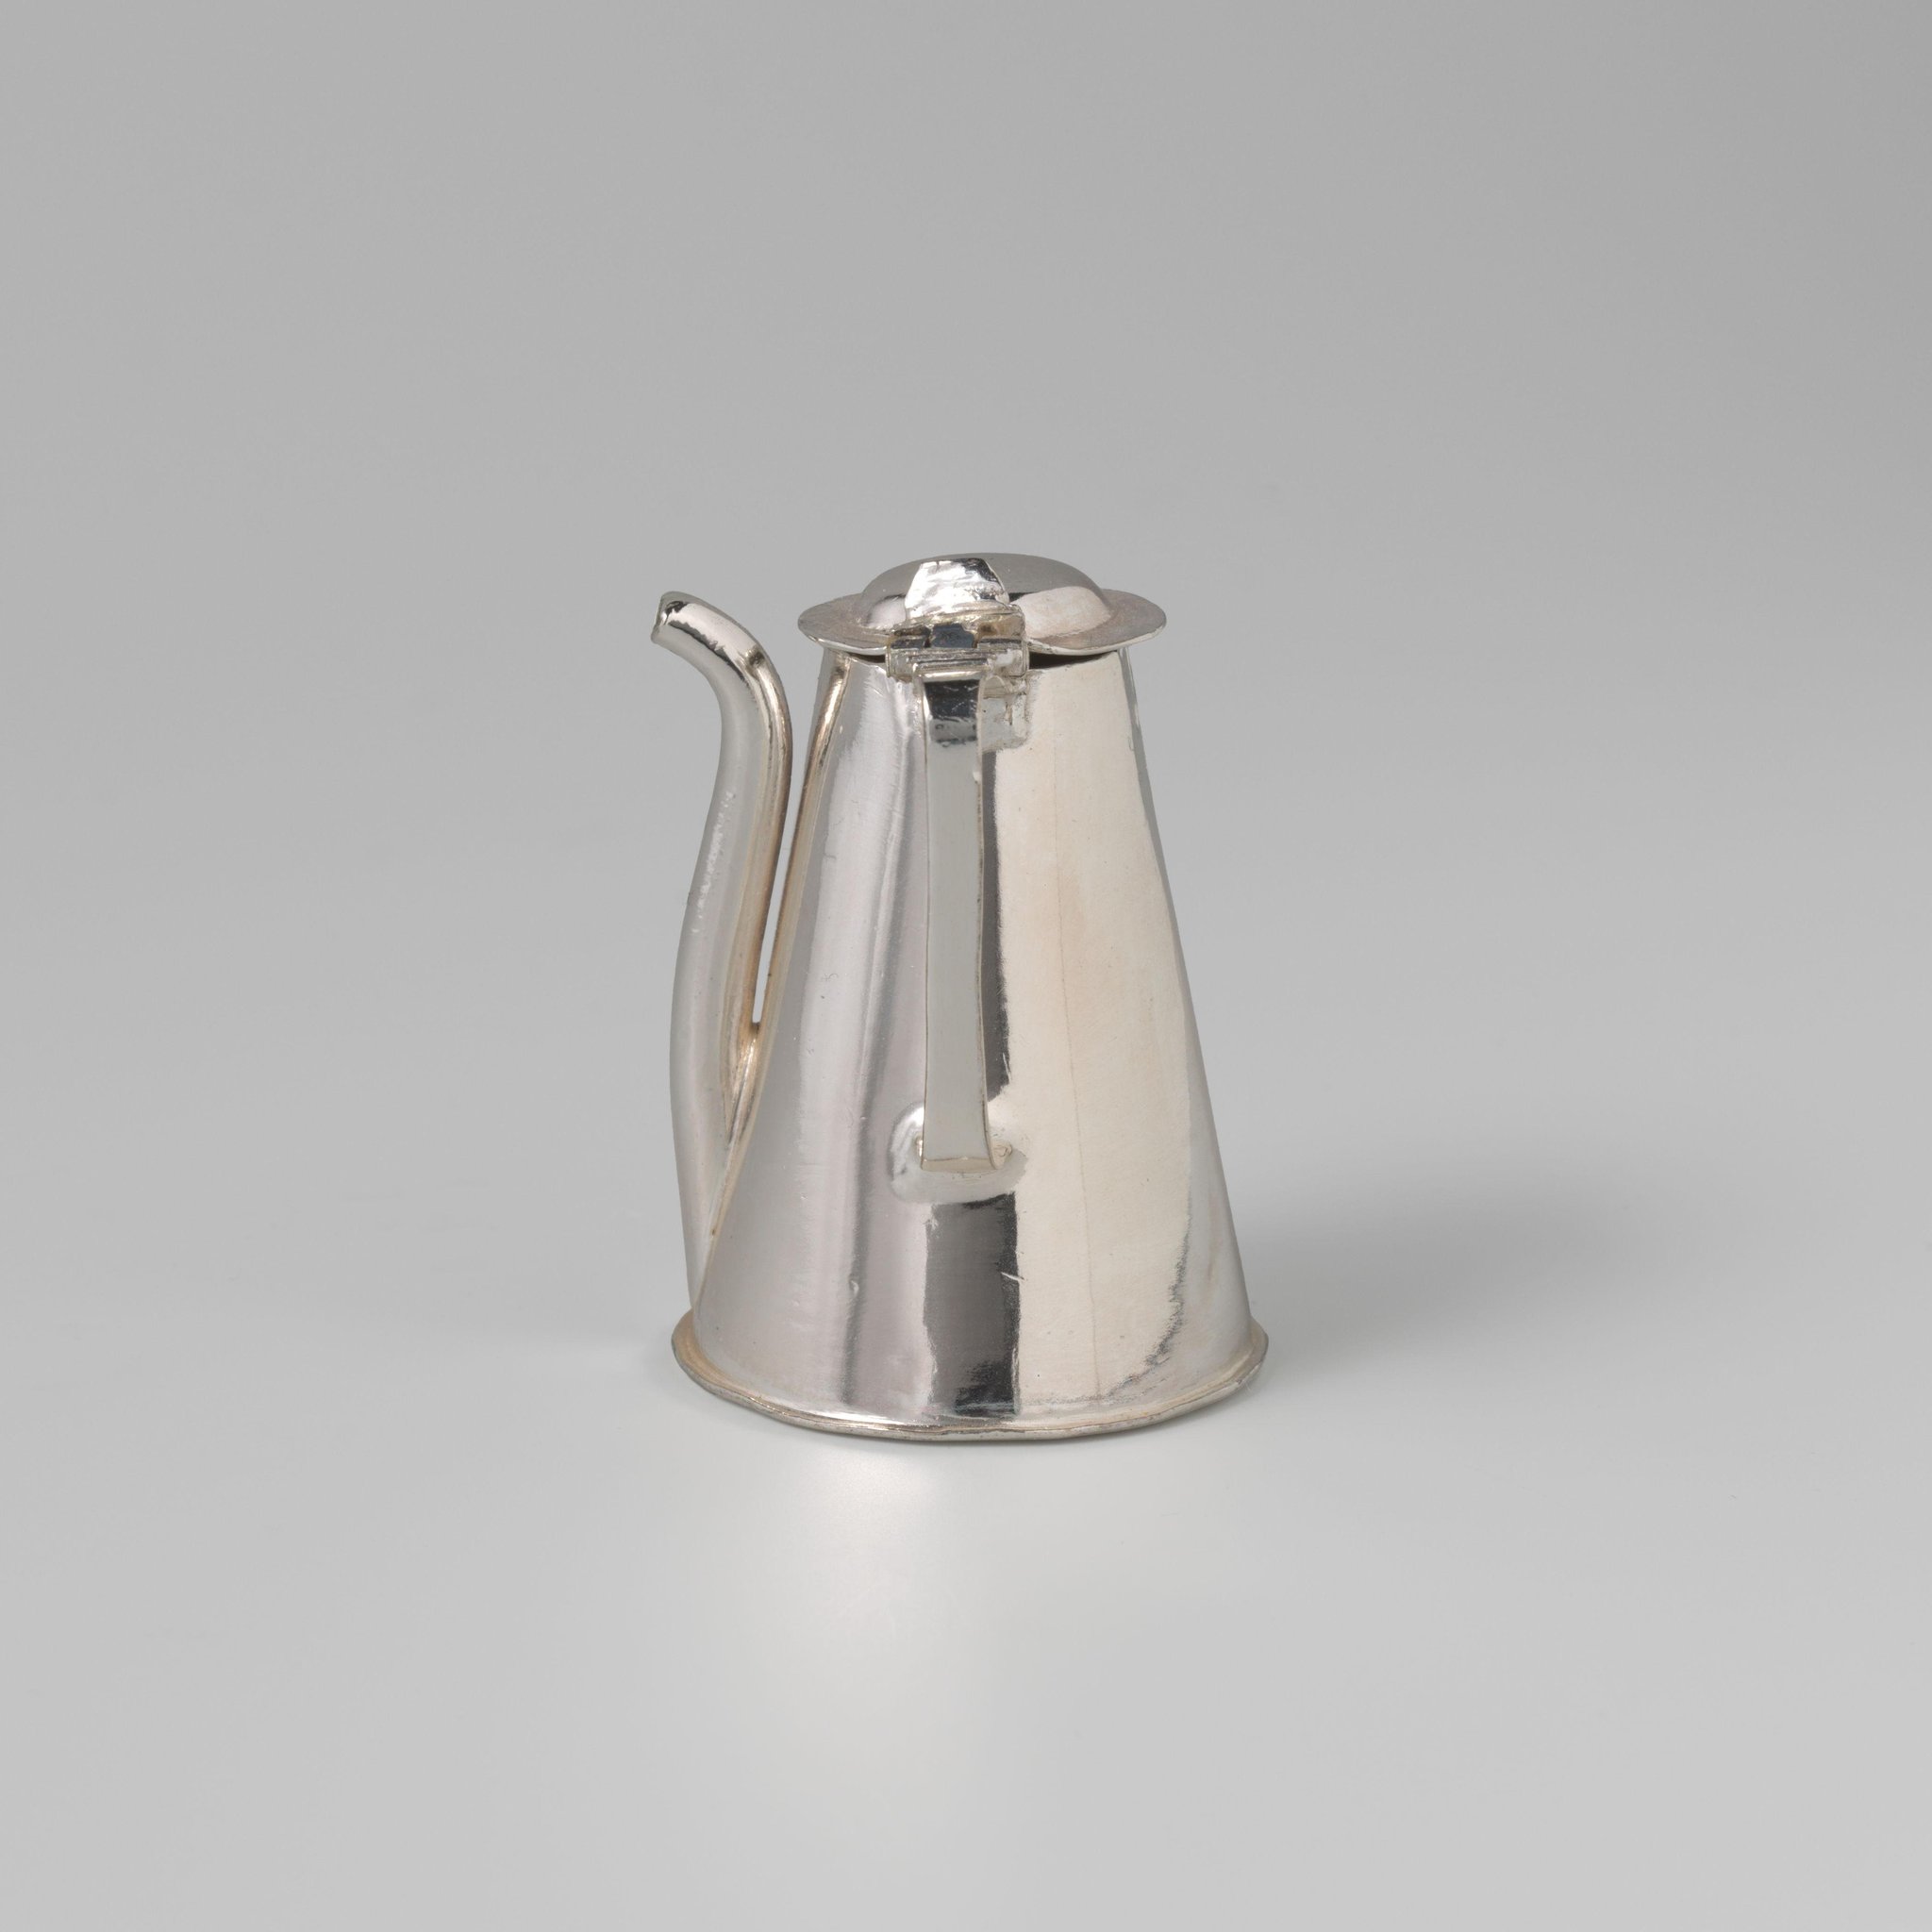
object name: miniature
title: Koffiekan van zilver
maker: Anonymous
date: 1650-1699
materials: silver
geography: amsterdam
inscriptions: maker's mark: ‘druiventros in rond (Citroen 1975, nr. 1066?)’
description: Koffiekan van zilver, conisch van vorm, met flauw gebogen tuit over de hele hoogte, scharnierend deksel. Het handvat is in een hoek van negentig graden ten opzichte van de tuit geplaatst.